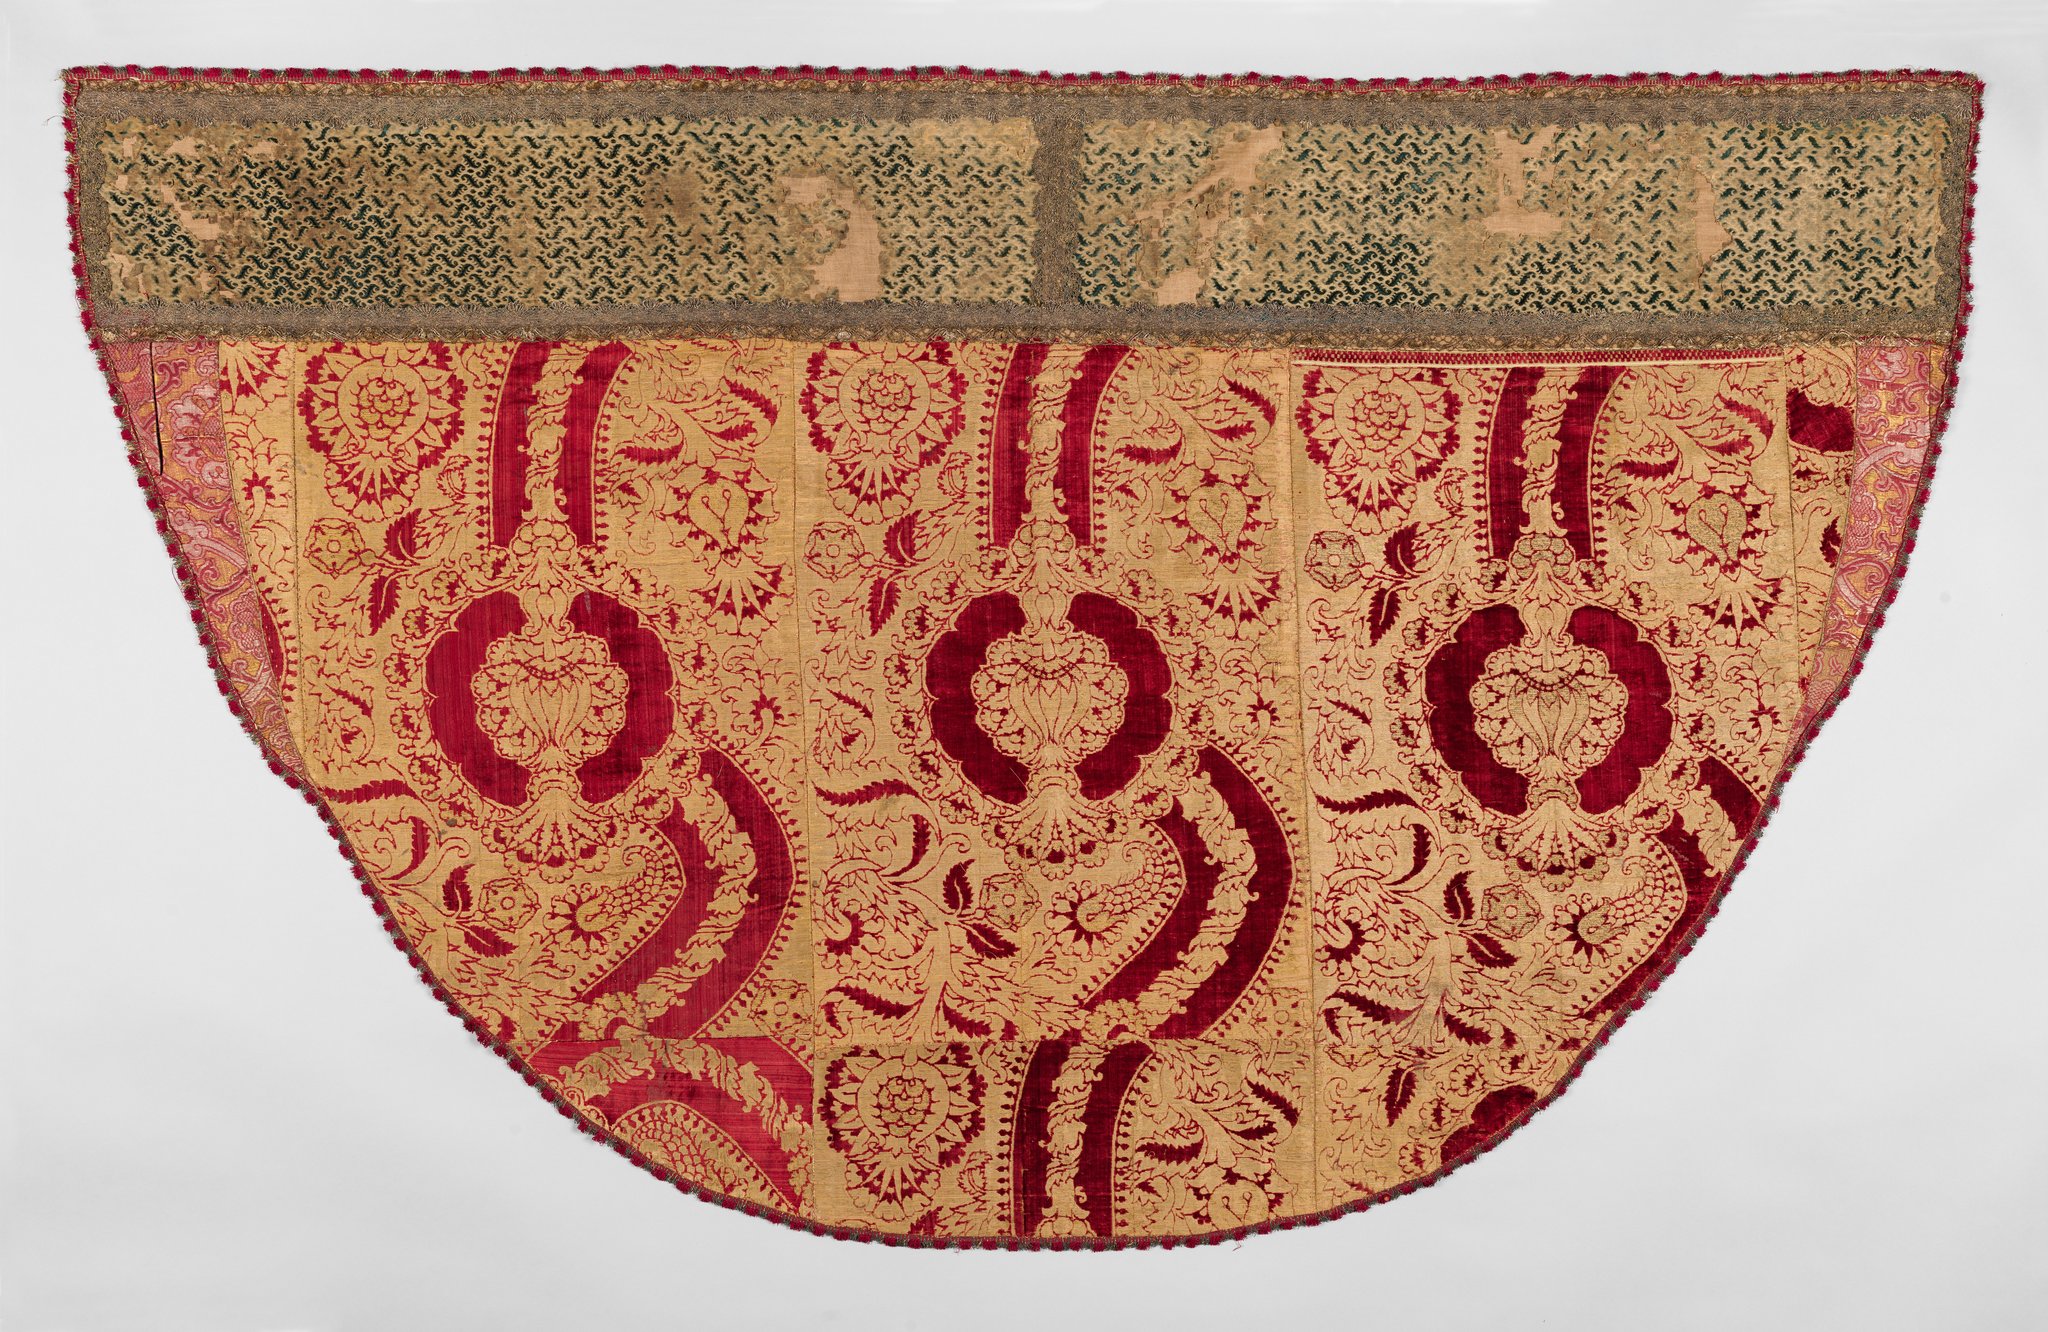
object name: cope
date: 1476-1500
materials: metal, silk